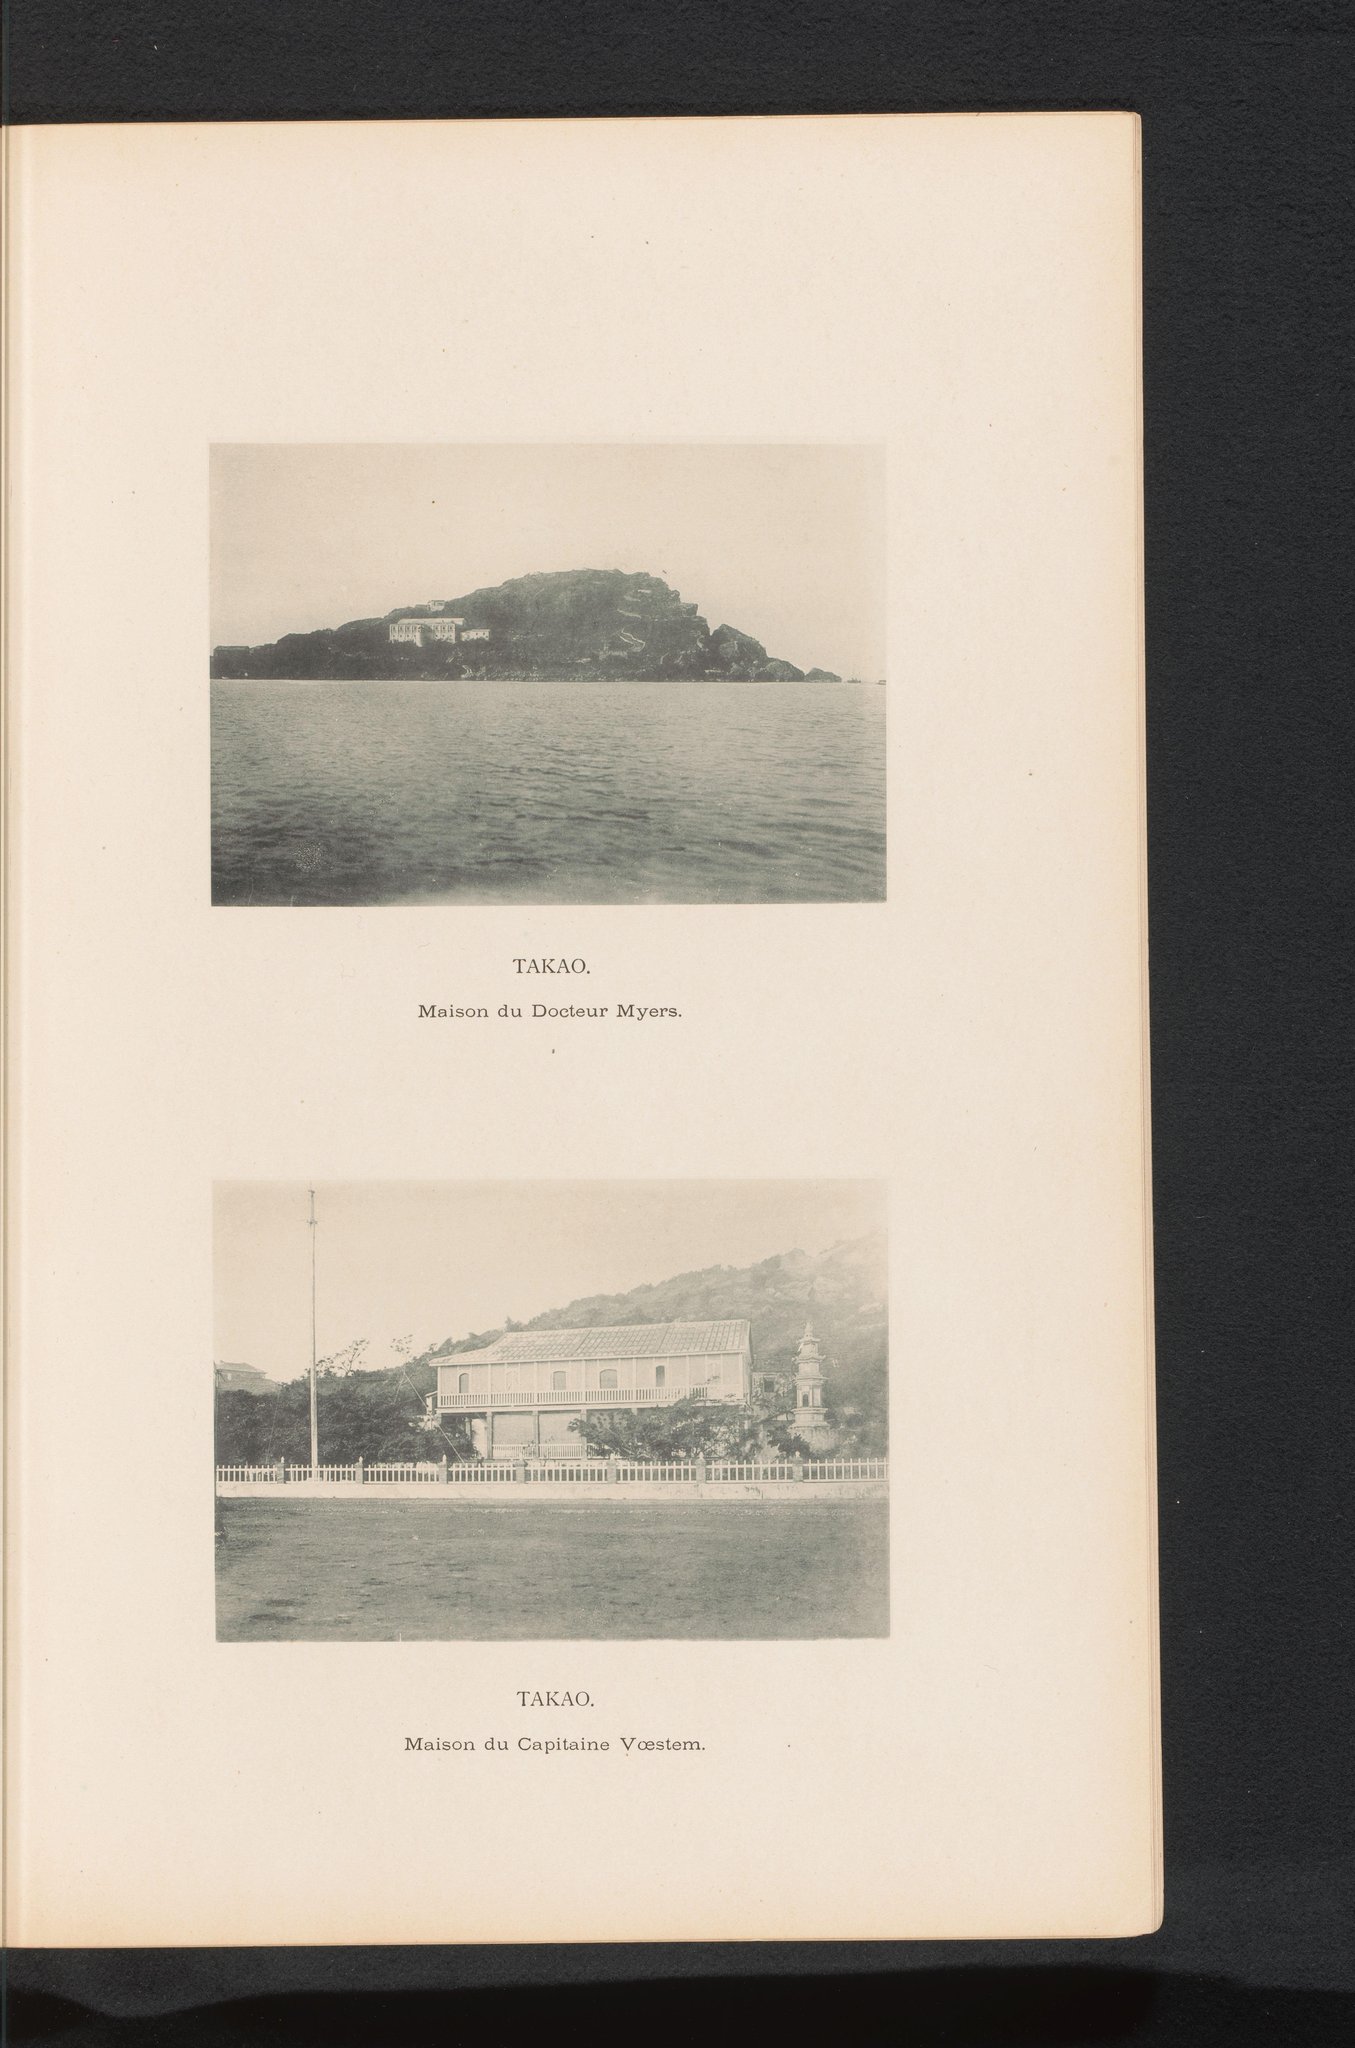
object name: photomechanical print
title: Gezicht op een woning en eiland te Taiwan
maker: Anonymous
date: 1891-1896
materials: paper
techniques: photograph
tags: island, rural housing, e.g. country-house, villa, cottage